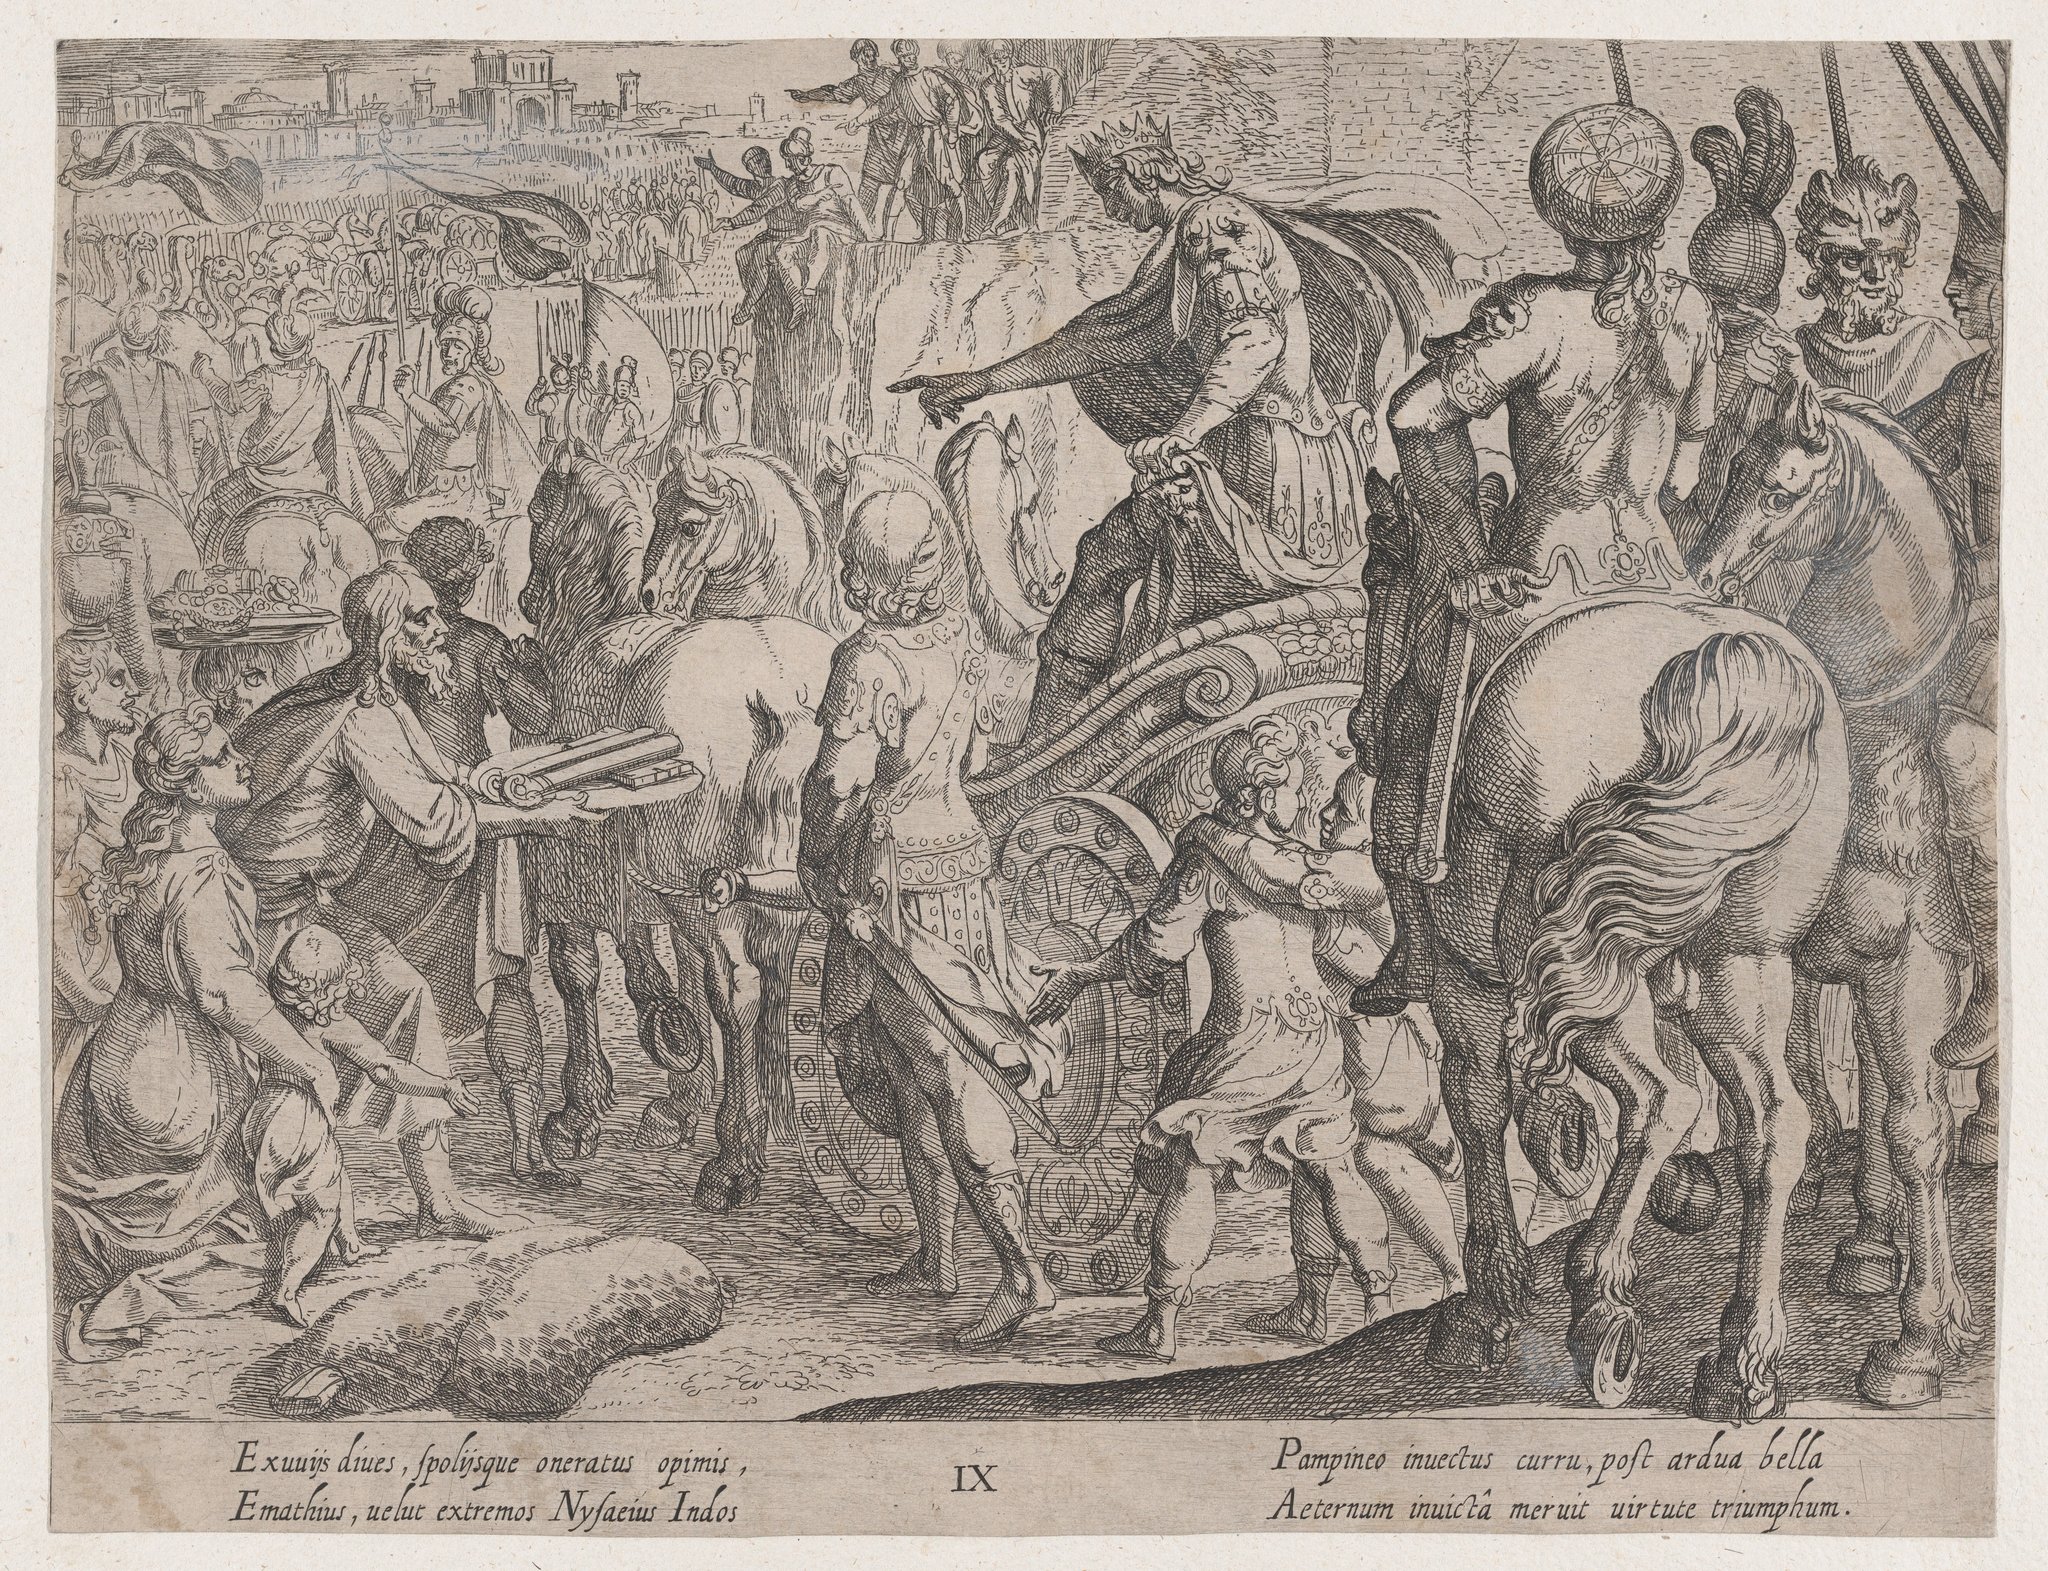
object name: print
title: Plate 9: Alexander's Triumphal Entry into Babylon, from "The Deeds of Alexander the Great"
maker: antonio tempesta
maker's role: artist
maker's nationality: italian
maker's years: 1555-1630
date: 1608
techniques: etching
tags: alexander the great,horses,crowd,chariots